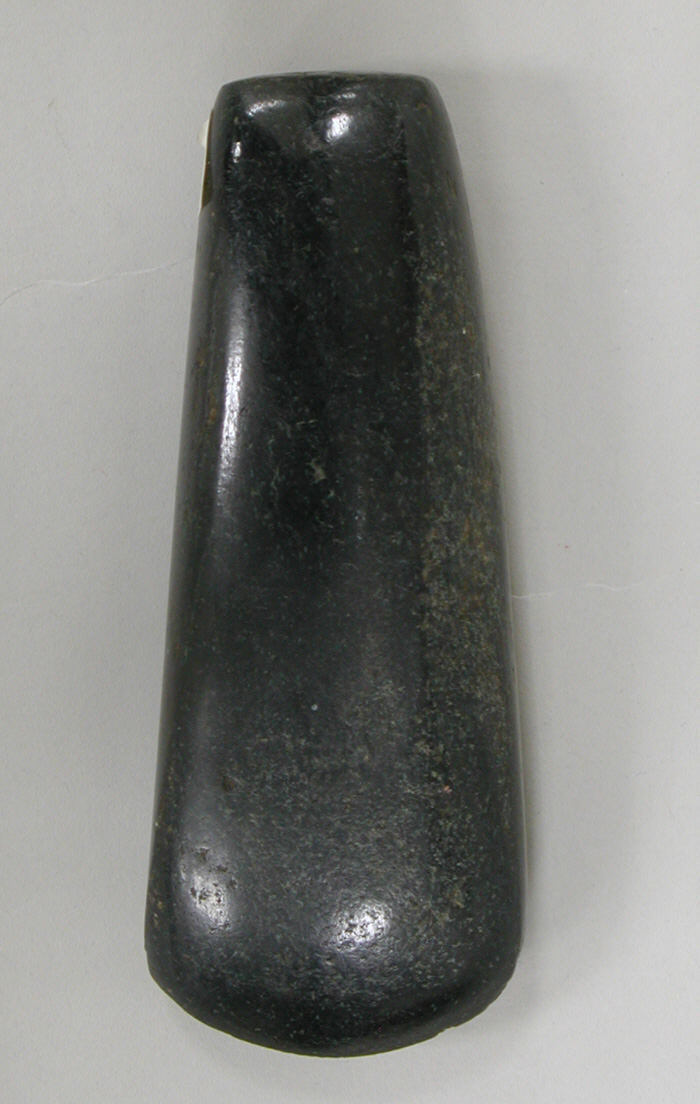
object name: celt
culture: maya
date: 1501-1600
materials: stone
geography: guatemala